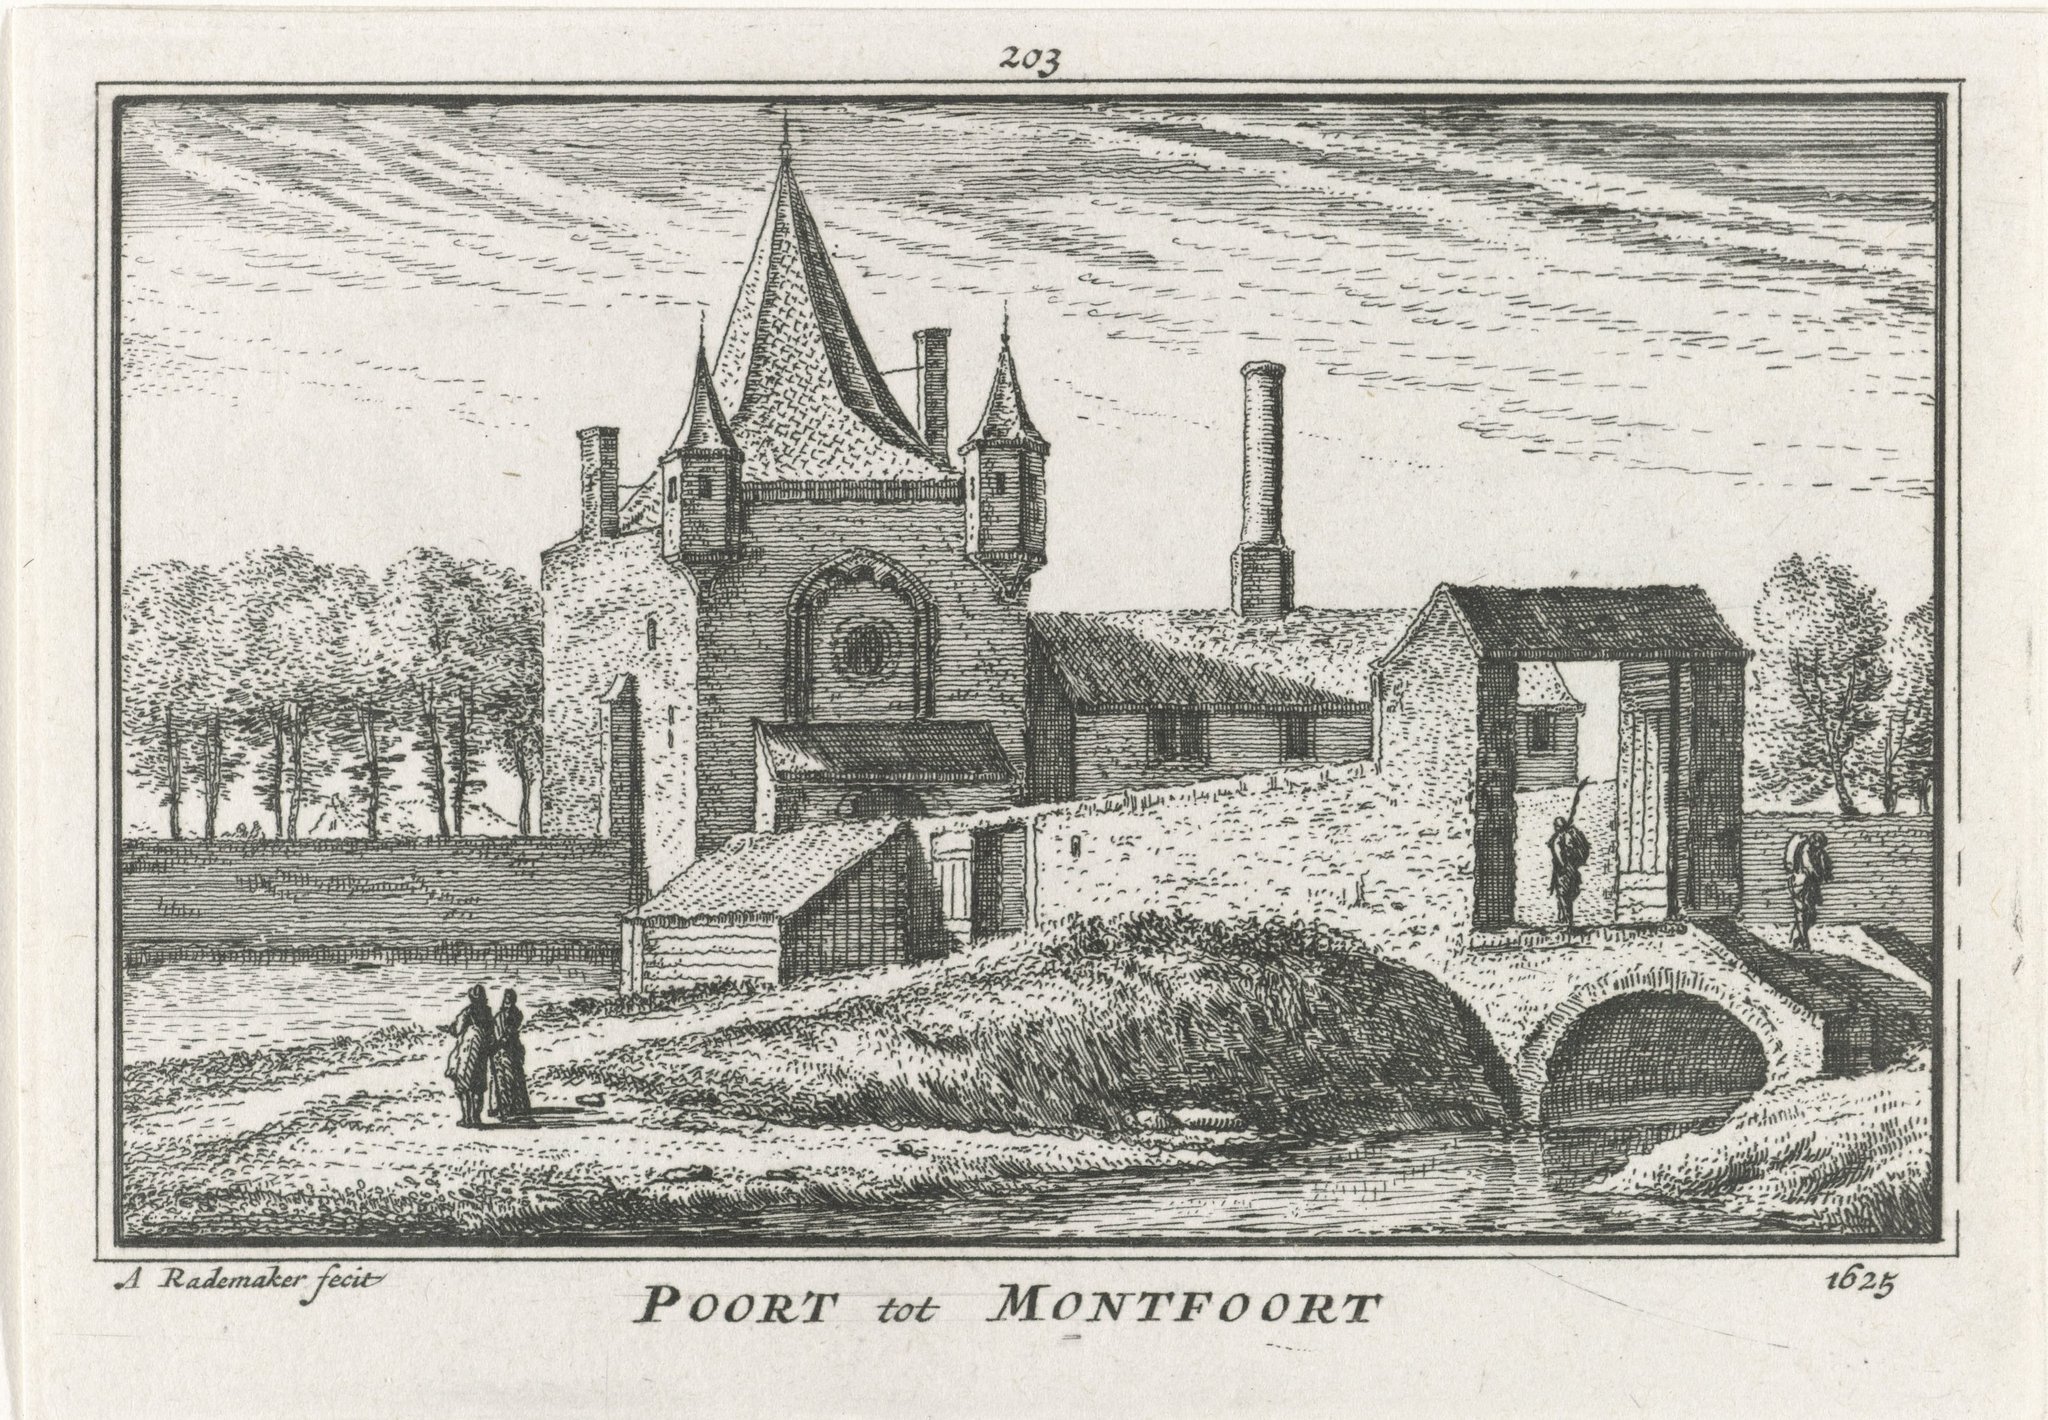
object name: book illustration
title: Gezicht op de IJsselpoort van Montfoort, 1625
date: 1727-1733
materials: paper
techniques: engraving, etching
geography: amsterdam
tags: 'en route', traveller under way, city-gate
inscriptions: collector's mark: Lugt 2228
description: Illustratie uit: Abraham Rademaker, Matthaeus Brouërius van Niedek, Isaac Le Long, Kabinet van Nederlandsche en Kleefsche outheden en (...) voorname stads- en landgebouwen, Willem Barents en Antoni Schoonenburg: Amsterdam, 1727-1733, ill. nr. 203.